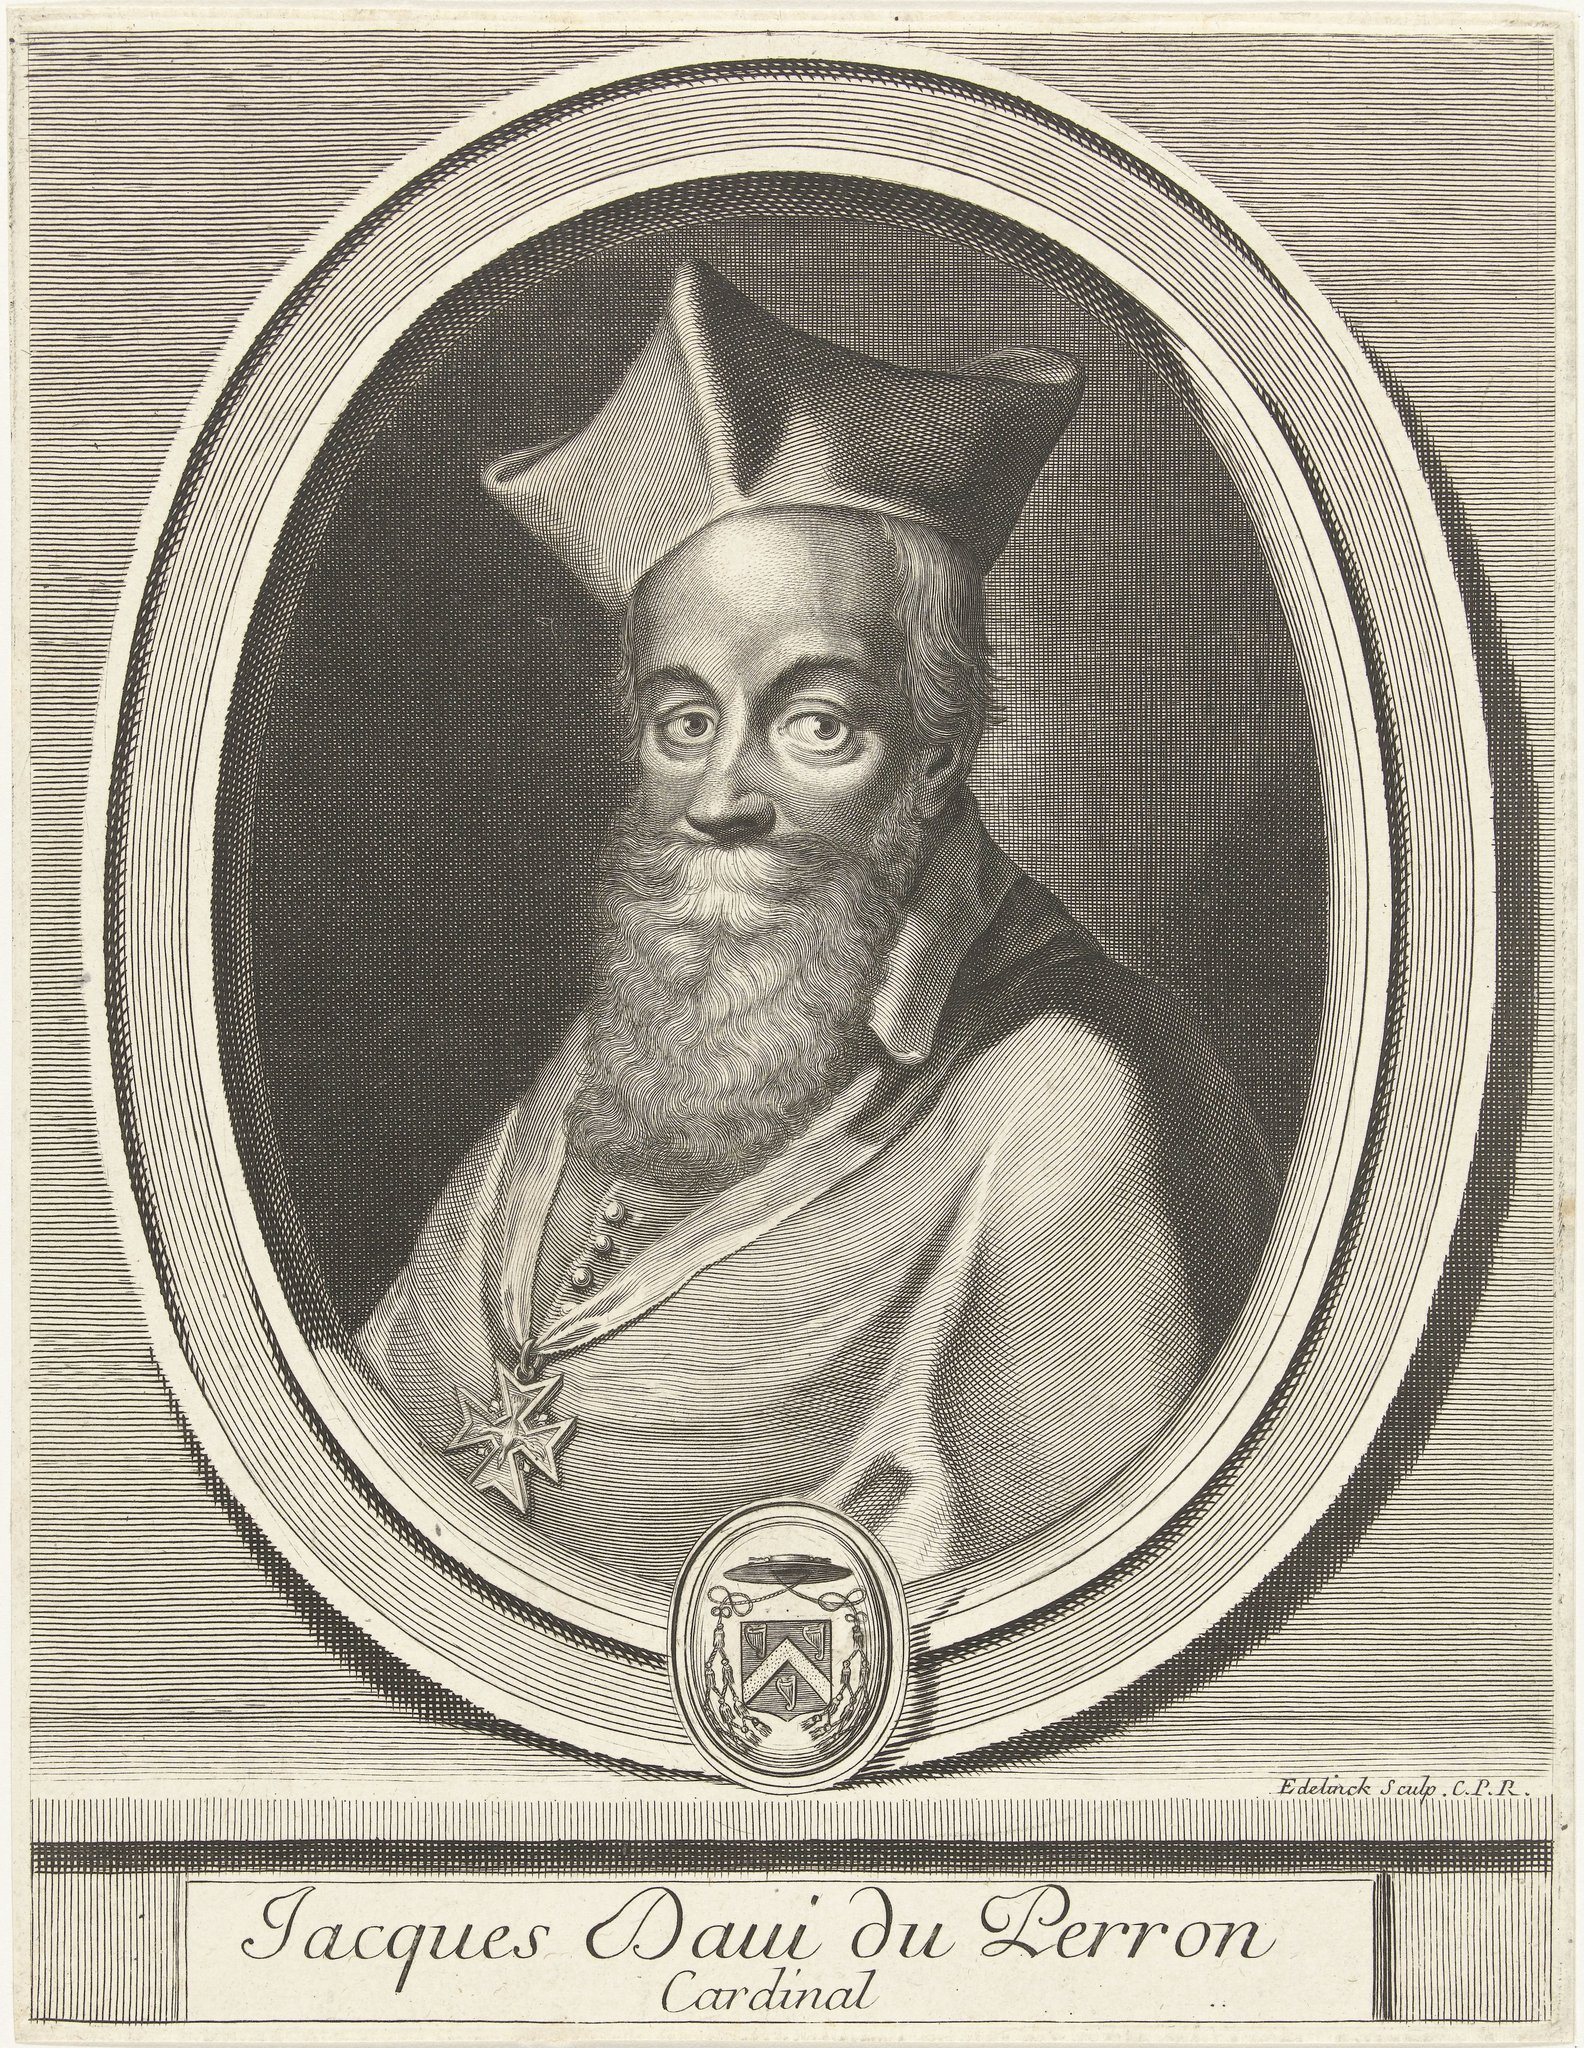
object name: print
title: Portret van Jacques Davy du Perron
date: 1666-1707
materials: paper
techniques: engraving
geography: paris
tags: normandië, kardinaal, jacques davy du perron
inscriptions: collector's mark: Lugt 2228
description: Busteportret van de kardinaal Jacques Davy du Perron (1556-1618), afgebeeld in ovaalvorige omlijsting met wapen.